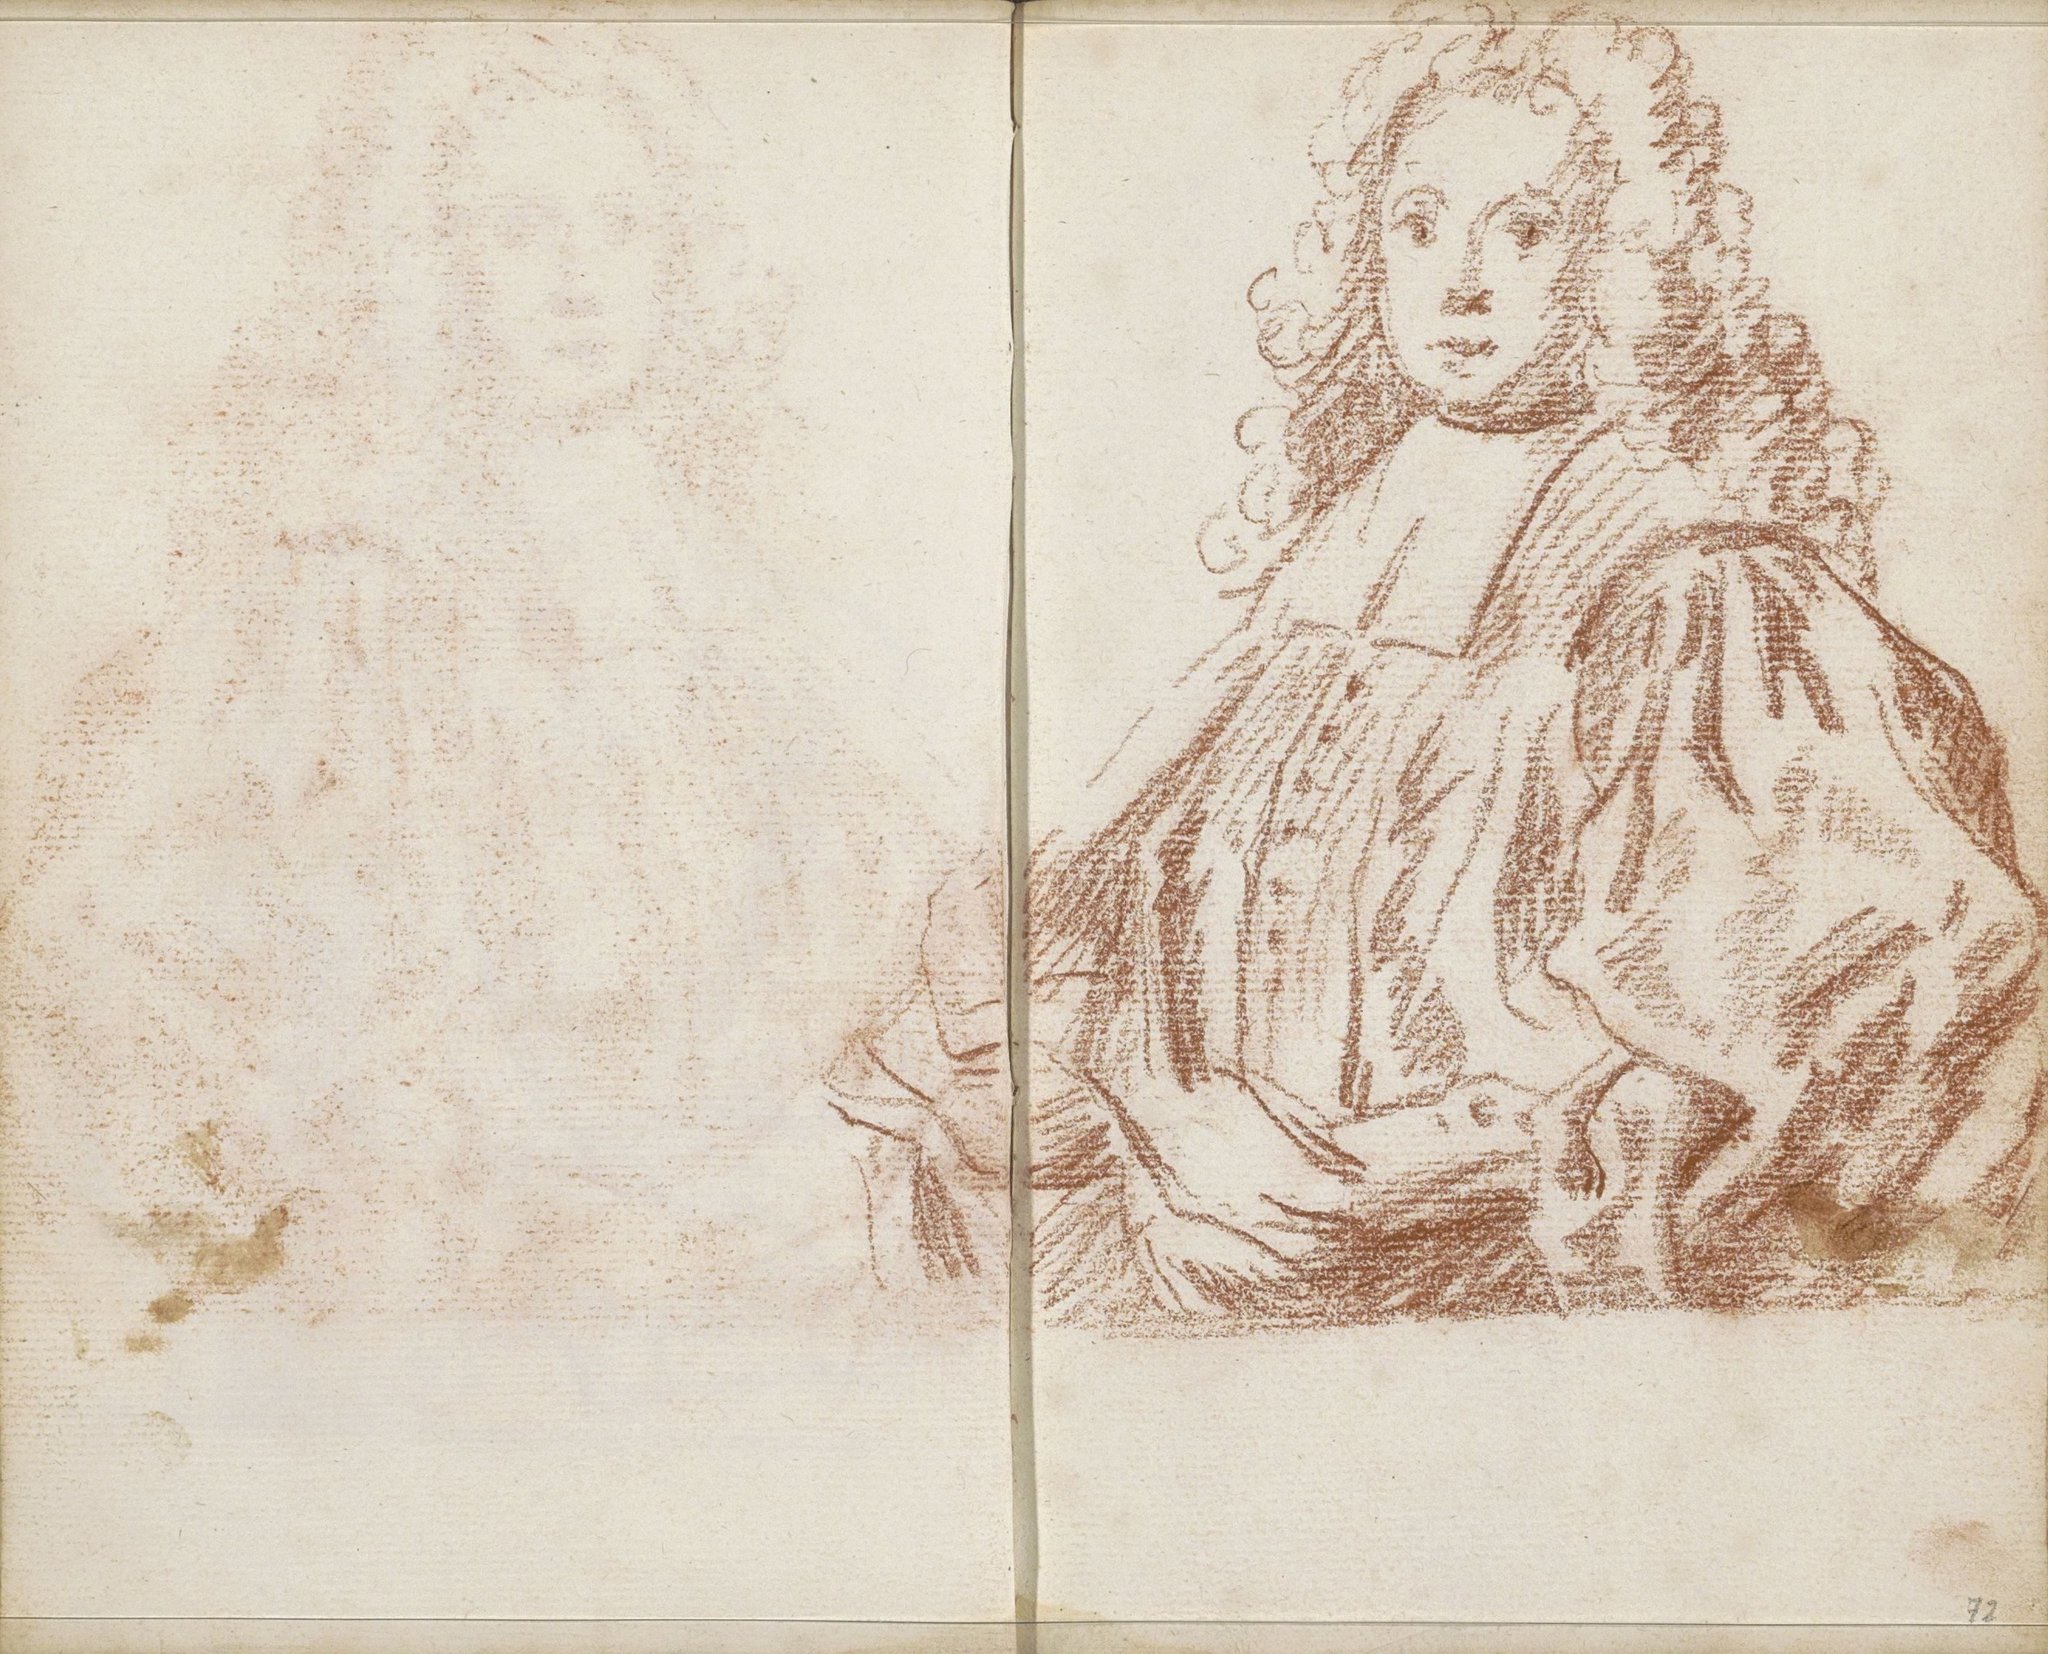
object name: sketchbook leaf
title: Portret van een onbekende man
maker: petrus johannes van reysschoot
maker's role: draughtsman, print maker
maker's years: 1702-1772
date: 1710-1772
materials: chalk, paper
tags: anonymous historical person portrayed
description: Blad 71 verso en 72 recto uit een schetsboek met 105 bladen.